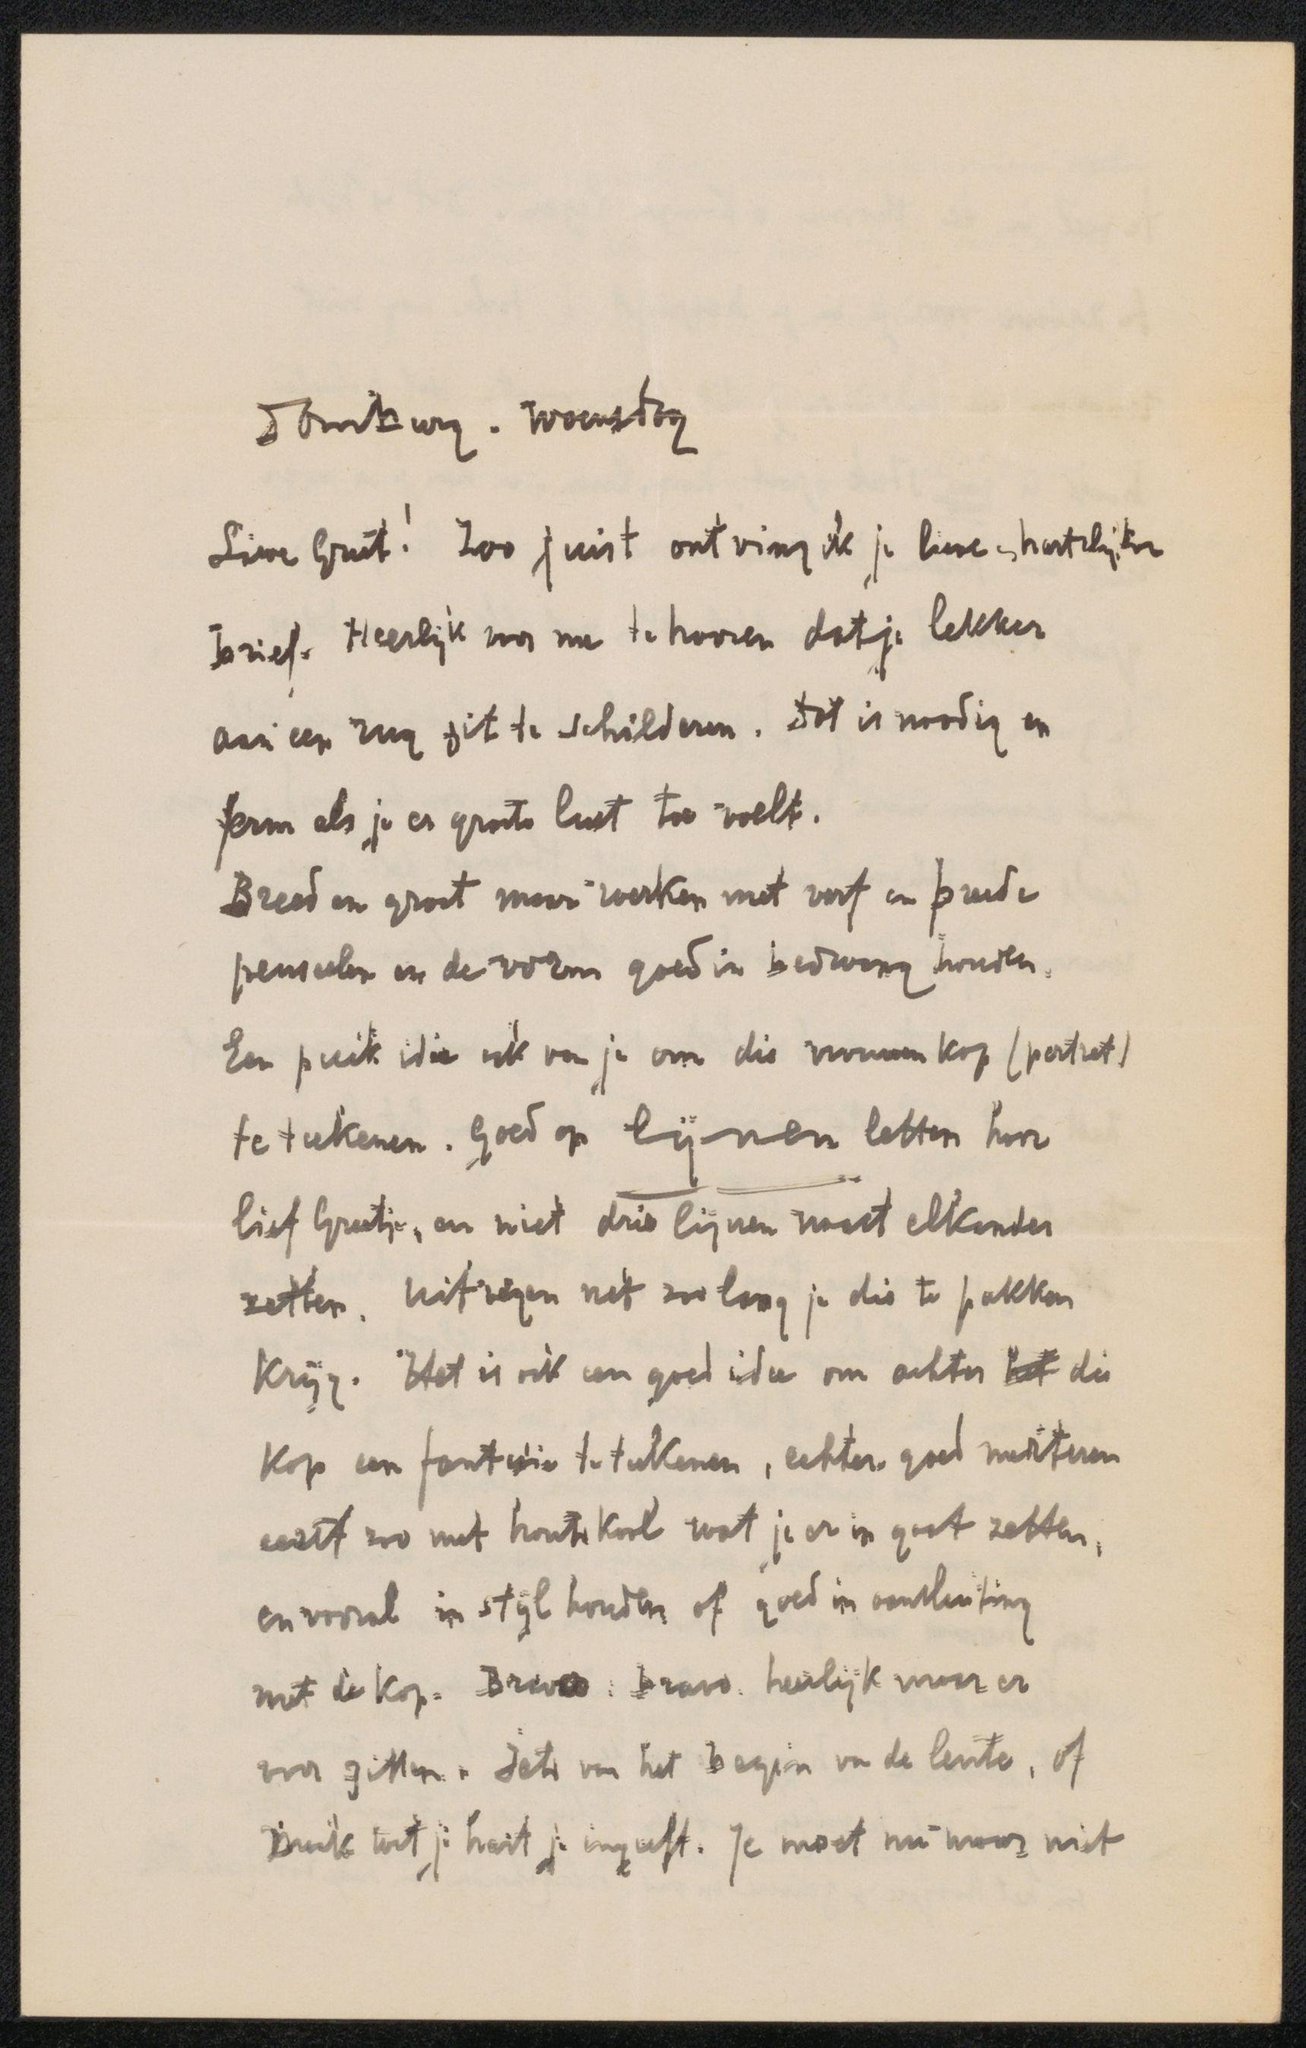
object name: letter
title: Brief aan Greet Feuerstein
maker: jan toorop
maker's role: draughtsman, painter, print maker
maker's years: 1858-1928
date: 1915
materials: ink, paper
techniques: pen, writing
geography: domburg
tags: the hague, print maker, greet feuerstein, painter, draughtsman, designer, jan verkade, drawing, anonymous historical person portrayed, painting (including book-illumination, miniature-painting), workshop, studio of the artist (in general), christian religion